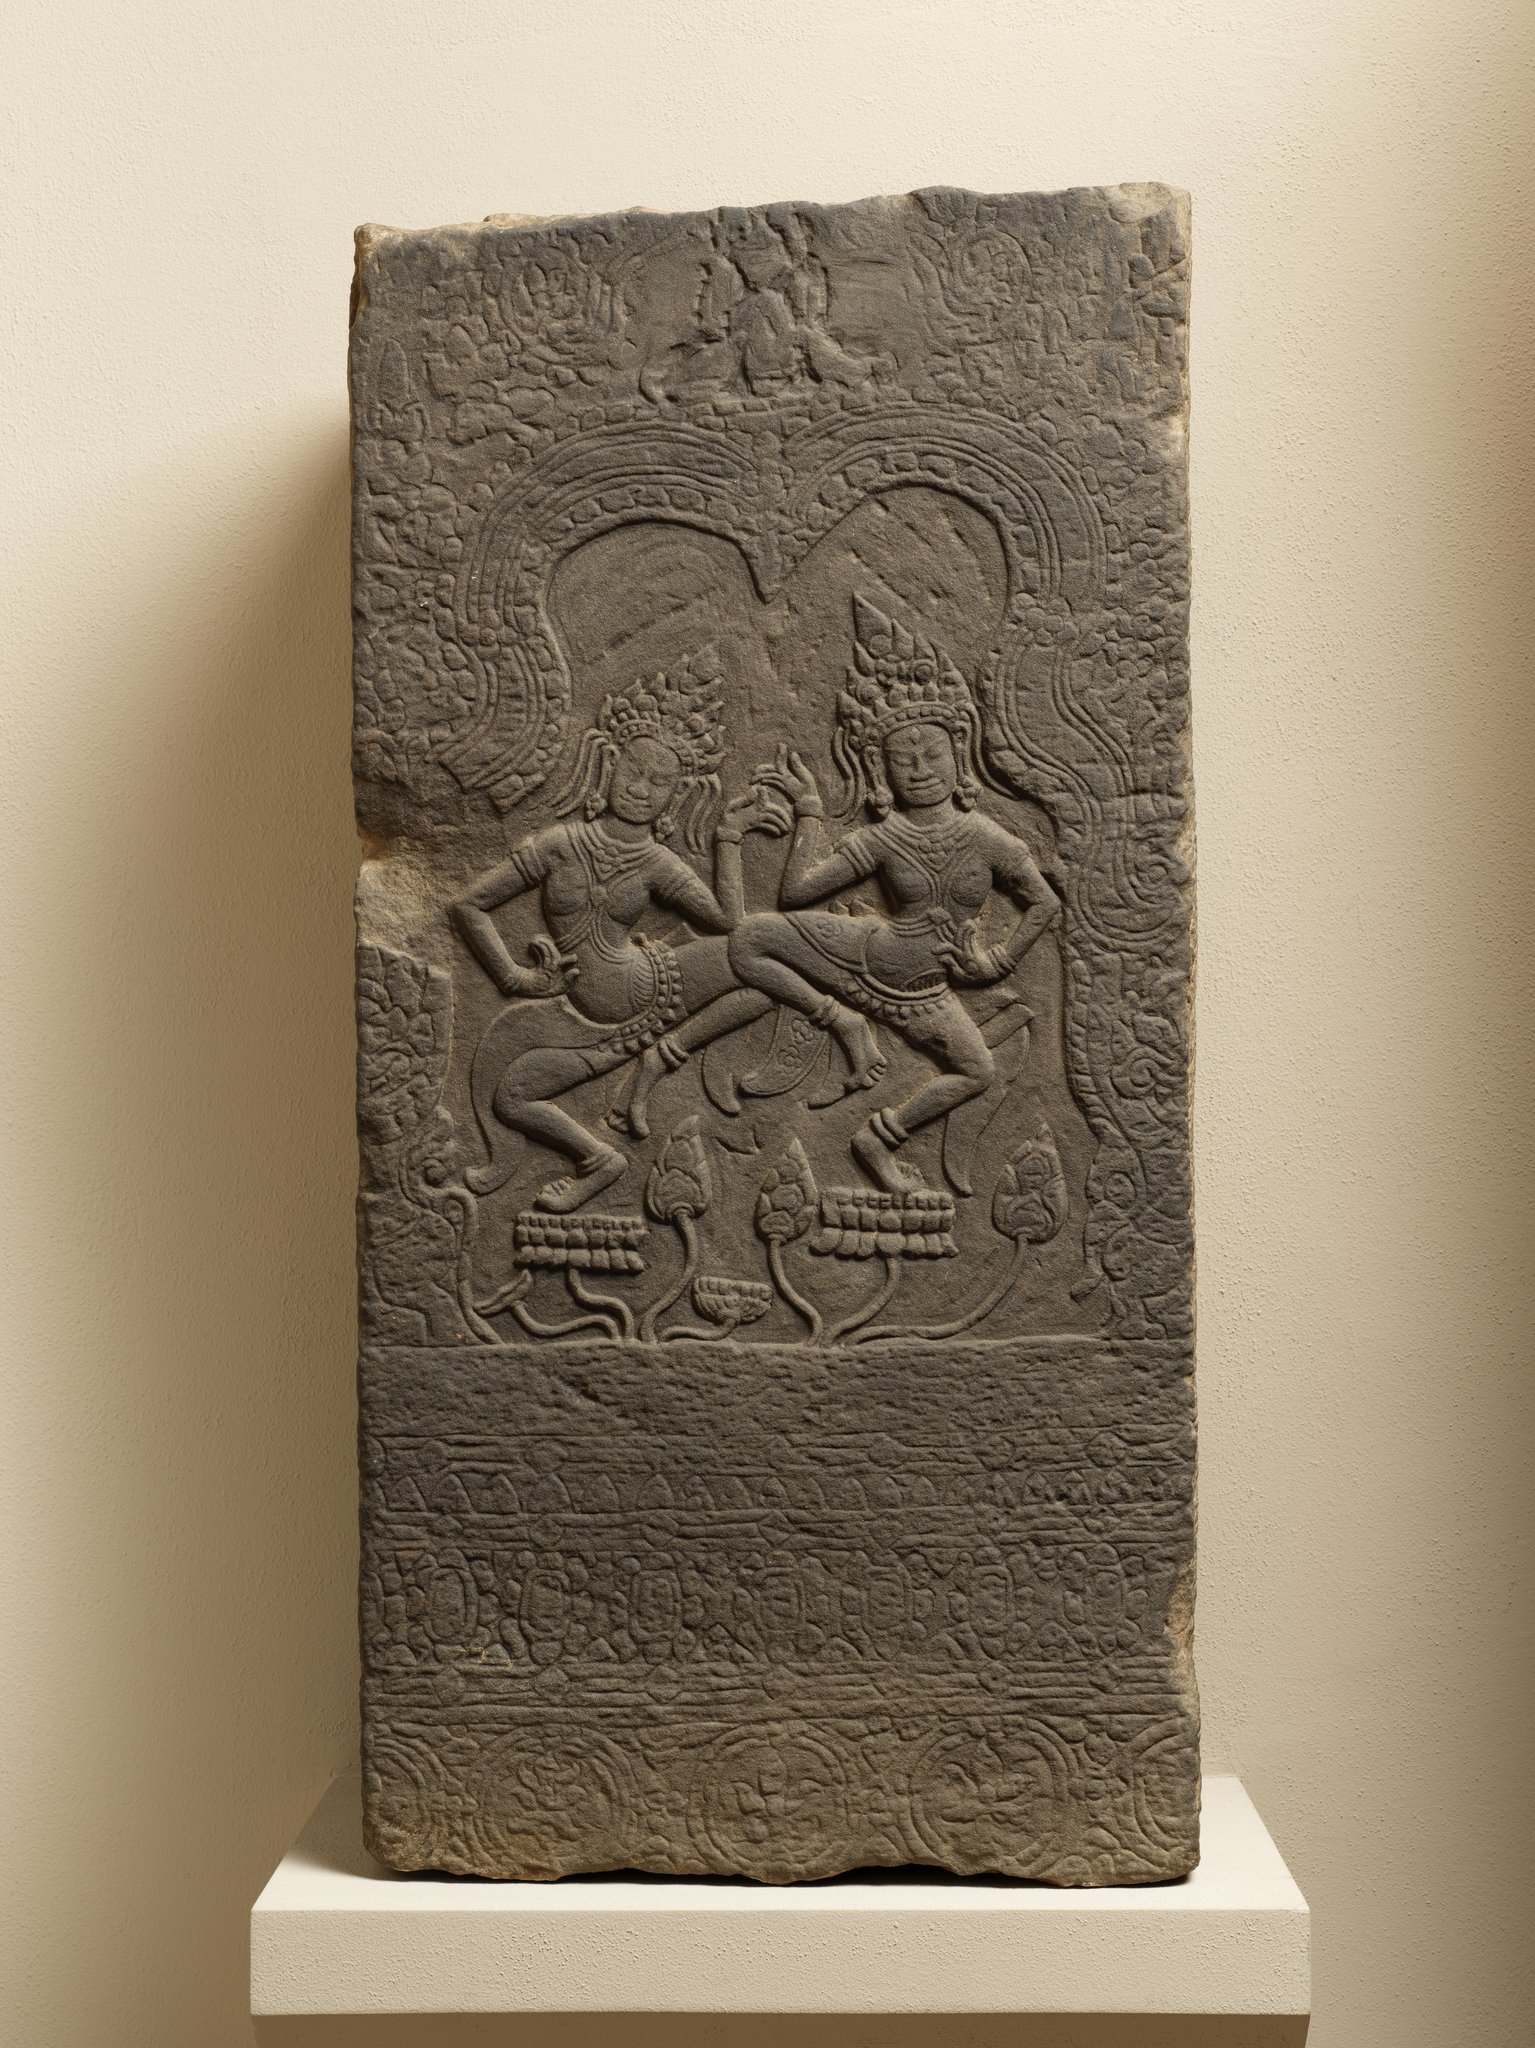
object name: pillar fragment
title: Pillar Fragment with Dancing Apsaras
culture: cambodian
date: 1167-1233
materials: stone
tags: dancing,lotuses,goddess,dancers